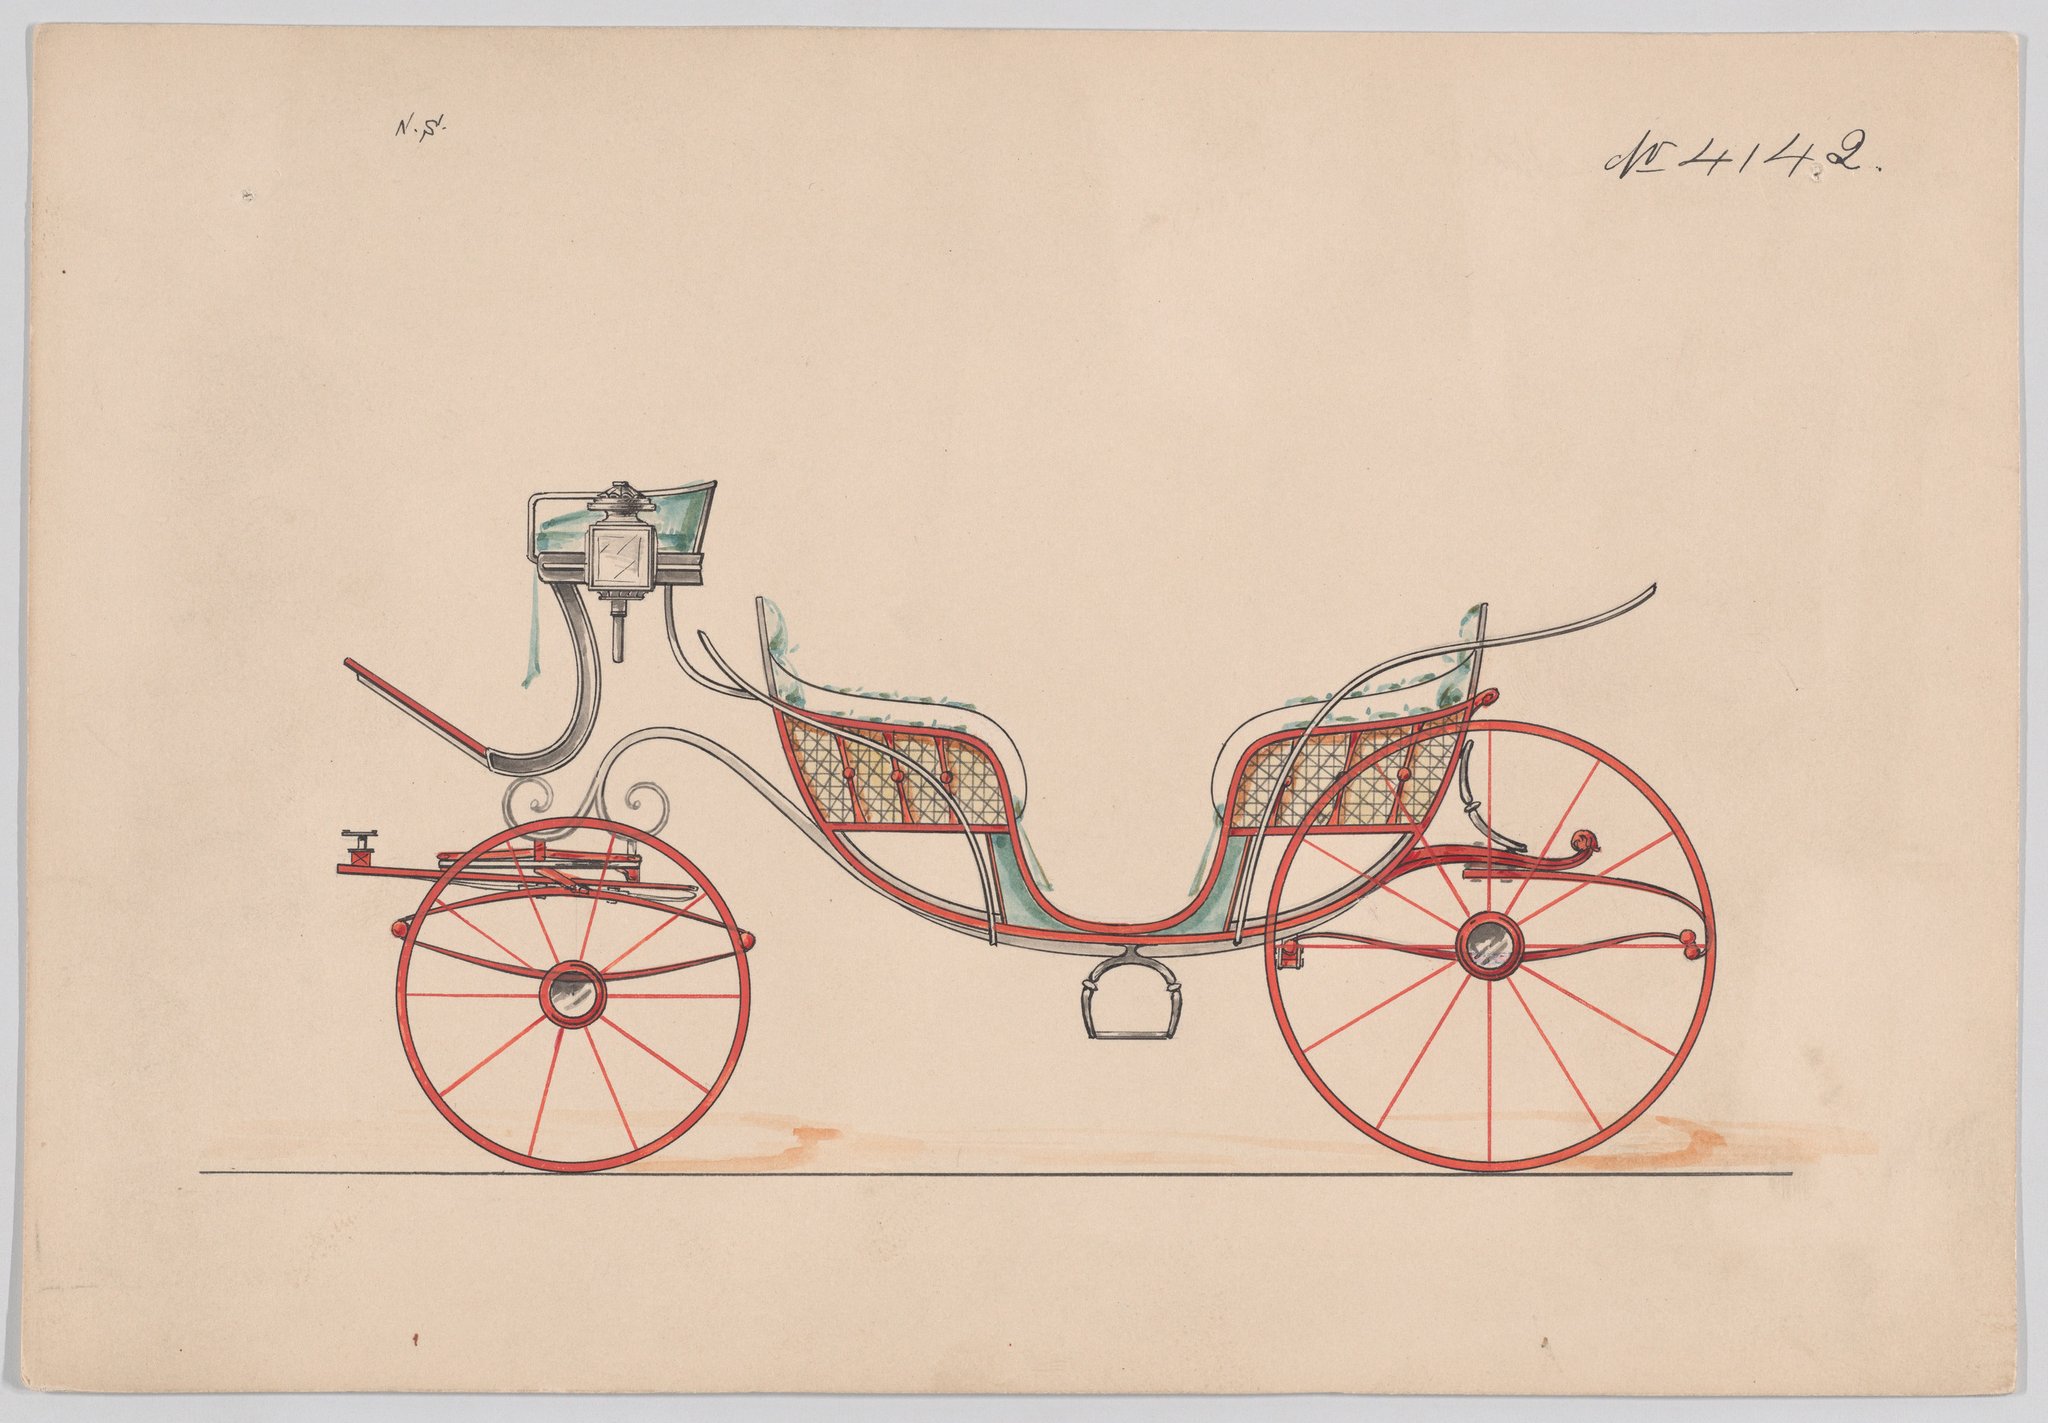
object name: drawing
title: Vis-a-Vis #4142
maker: brewster & co.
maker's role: manufacturer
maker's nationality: american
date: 1891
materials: gouache, ink, watercolor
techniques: pen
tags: carriages